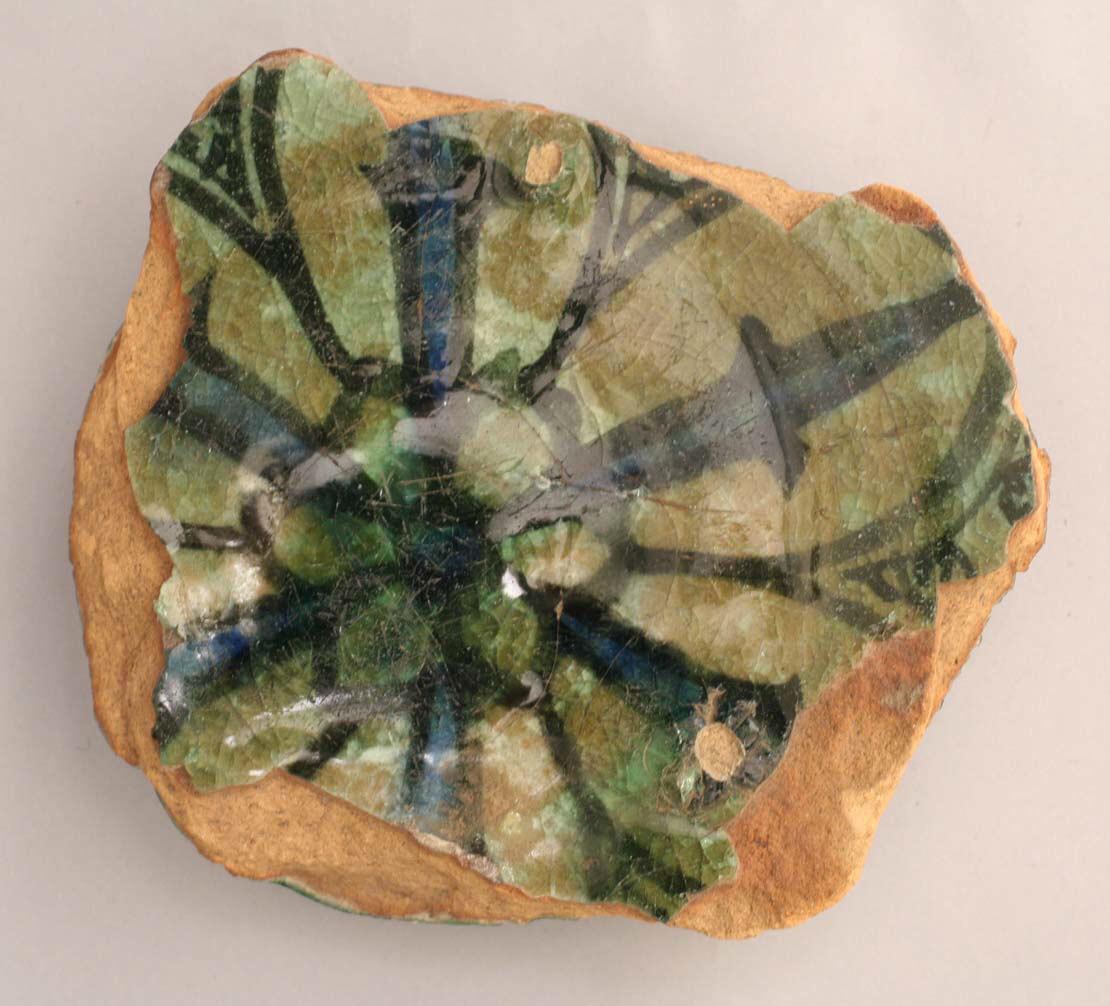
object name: ceramic fragment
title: Fragment of a Dish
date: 1301-1500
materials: earthenware, glaze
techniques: painting, polychrome, underglaze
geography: egypt